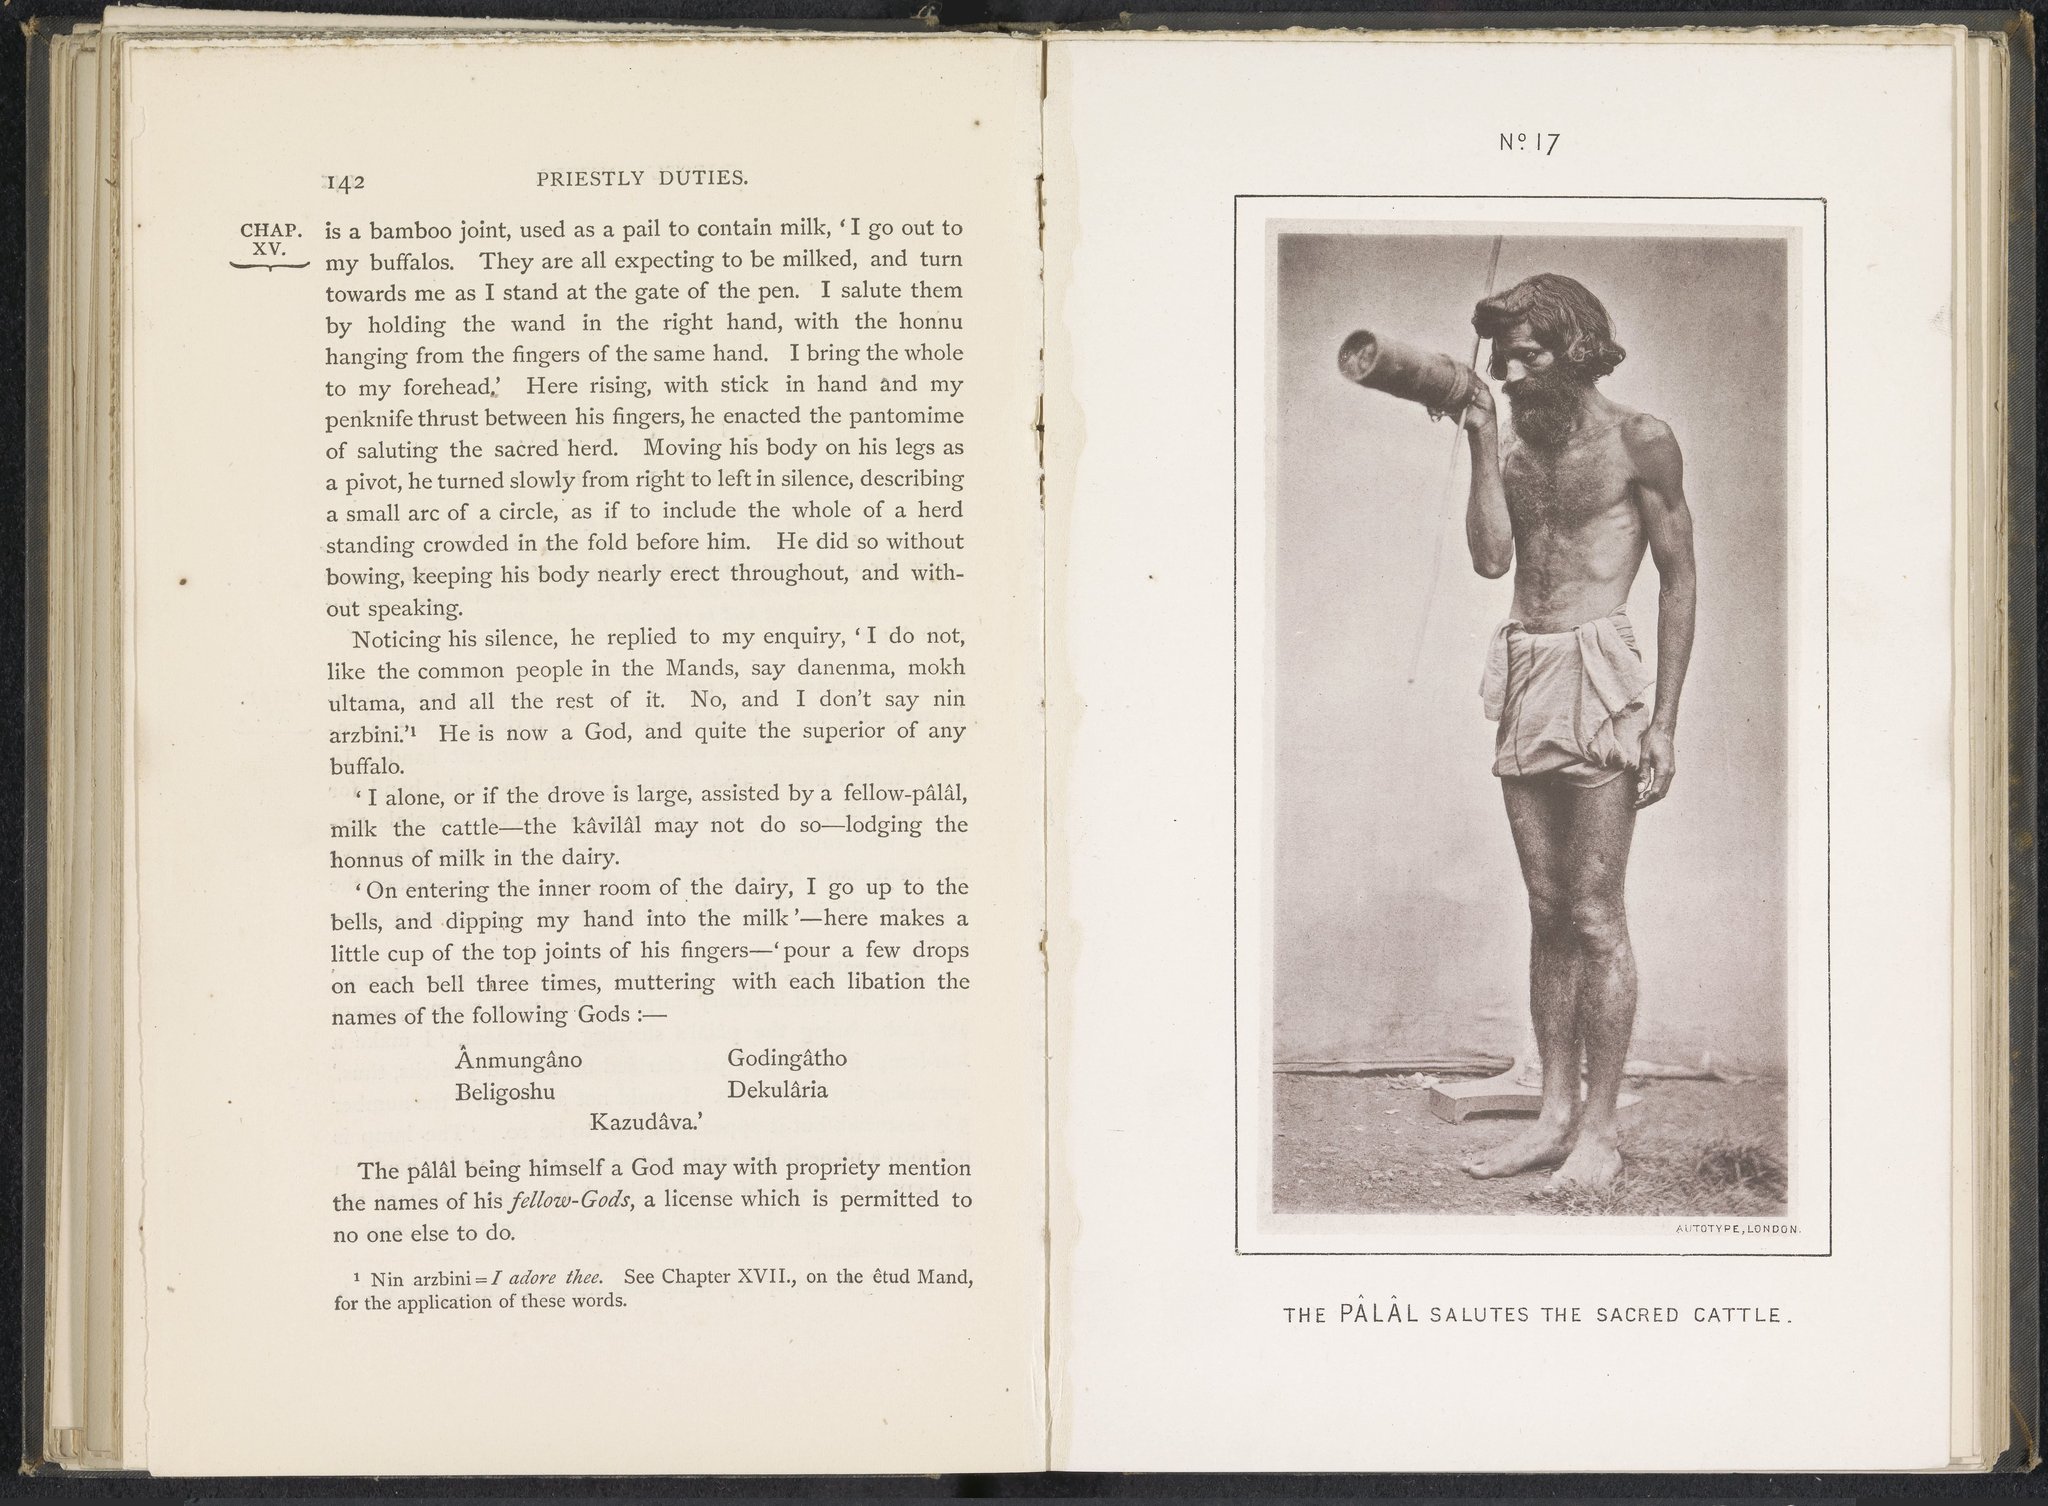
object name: page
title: The pâlâl salutes the sacred cattle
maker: Anonymous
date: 1863-1873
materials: paper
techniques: photograph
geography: london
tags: priest ~ non-christian religions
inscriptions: number: ‘No. 17’